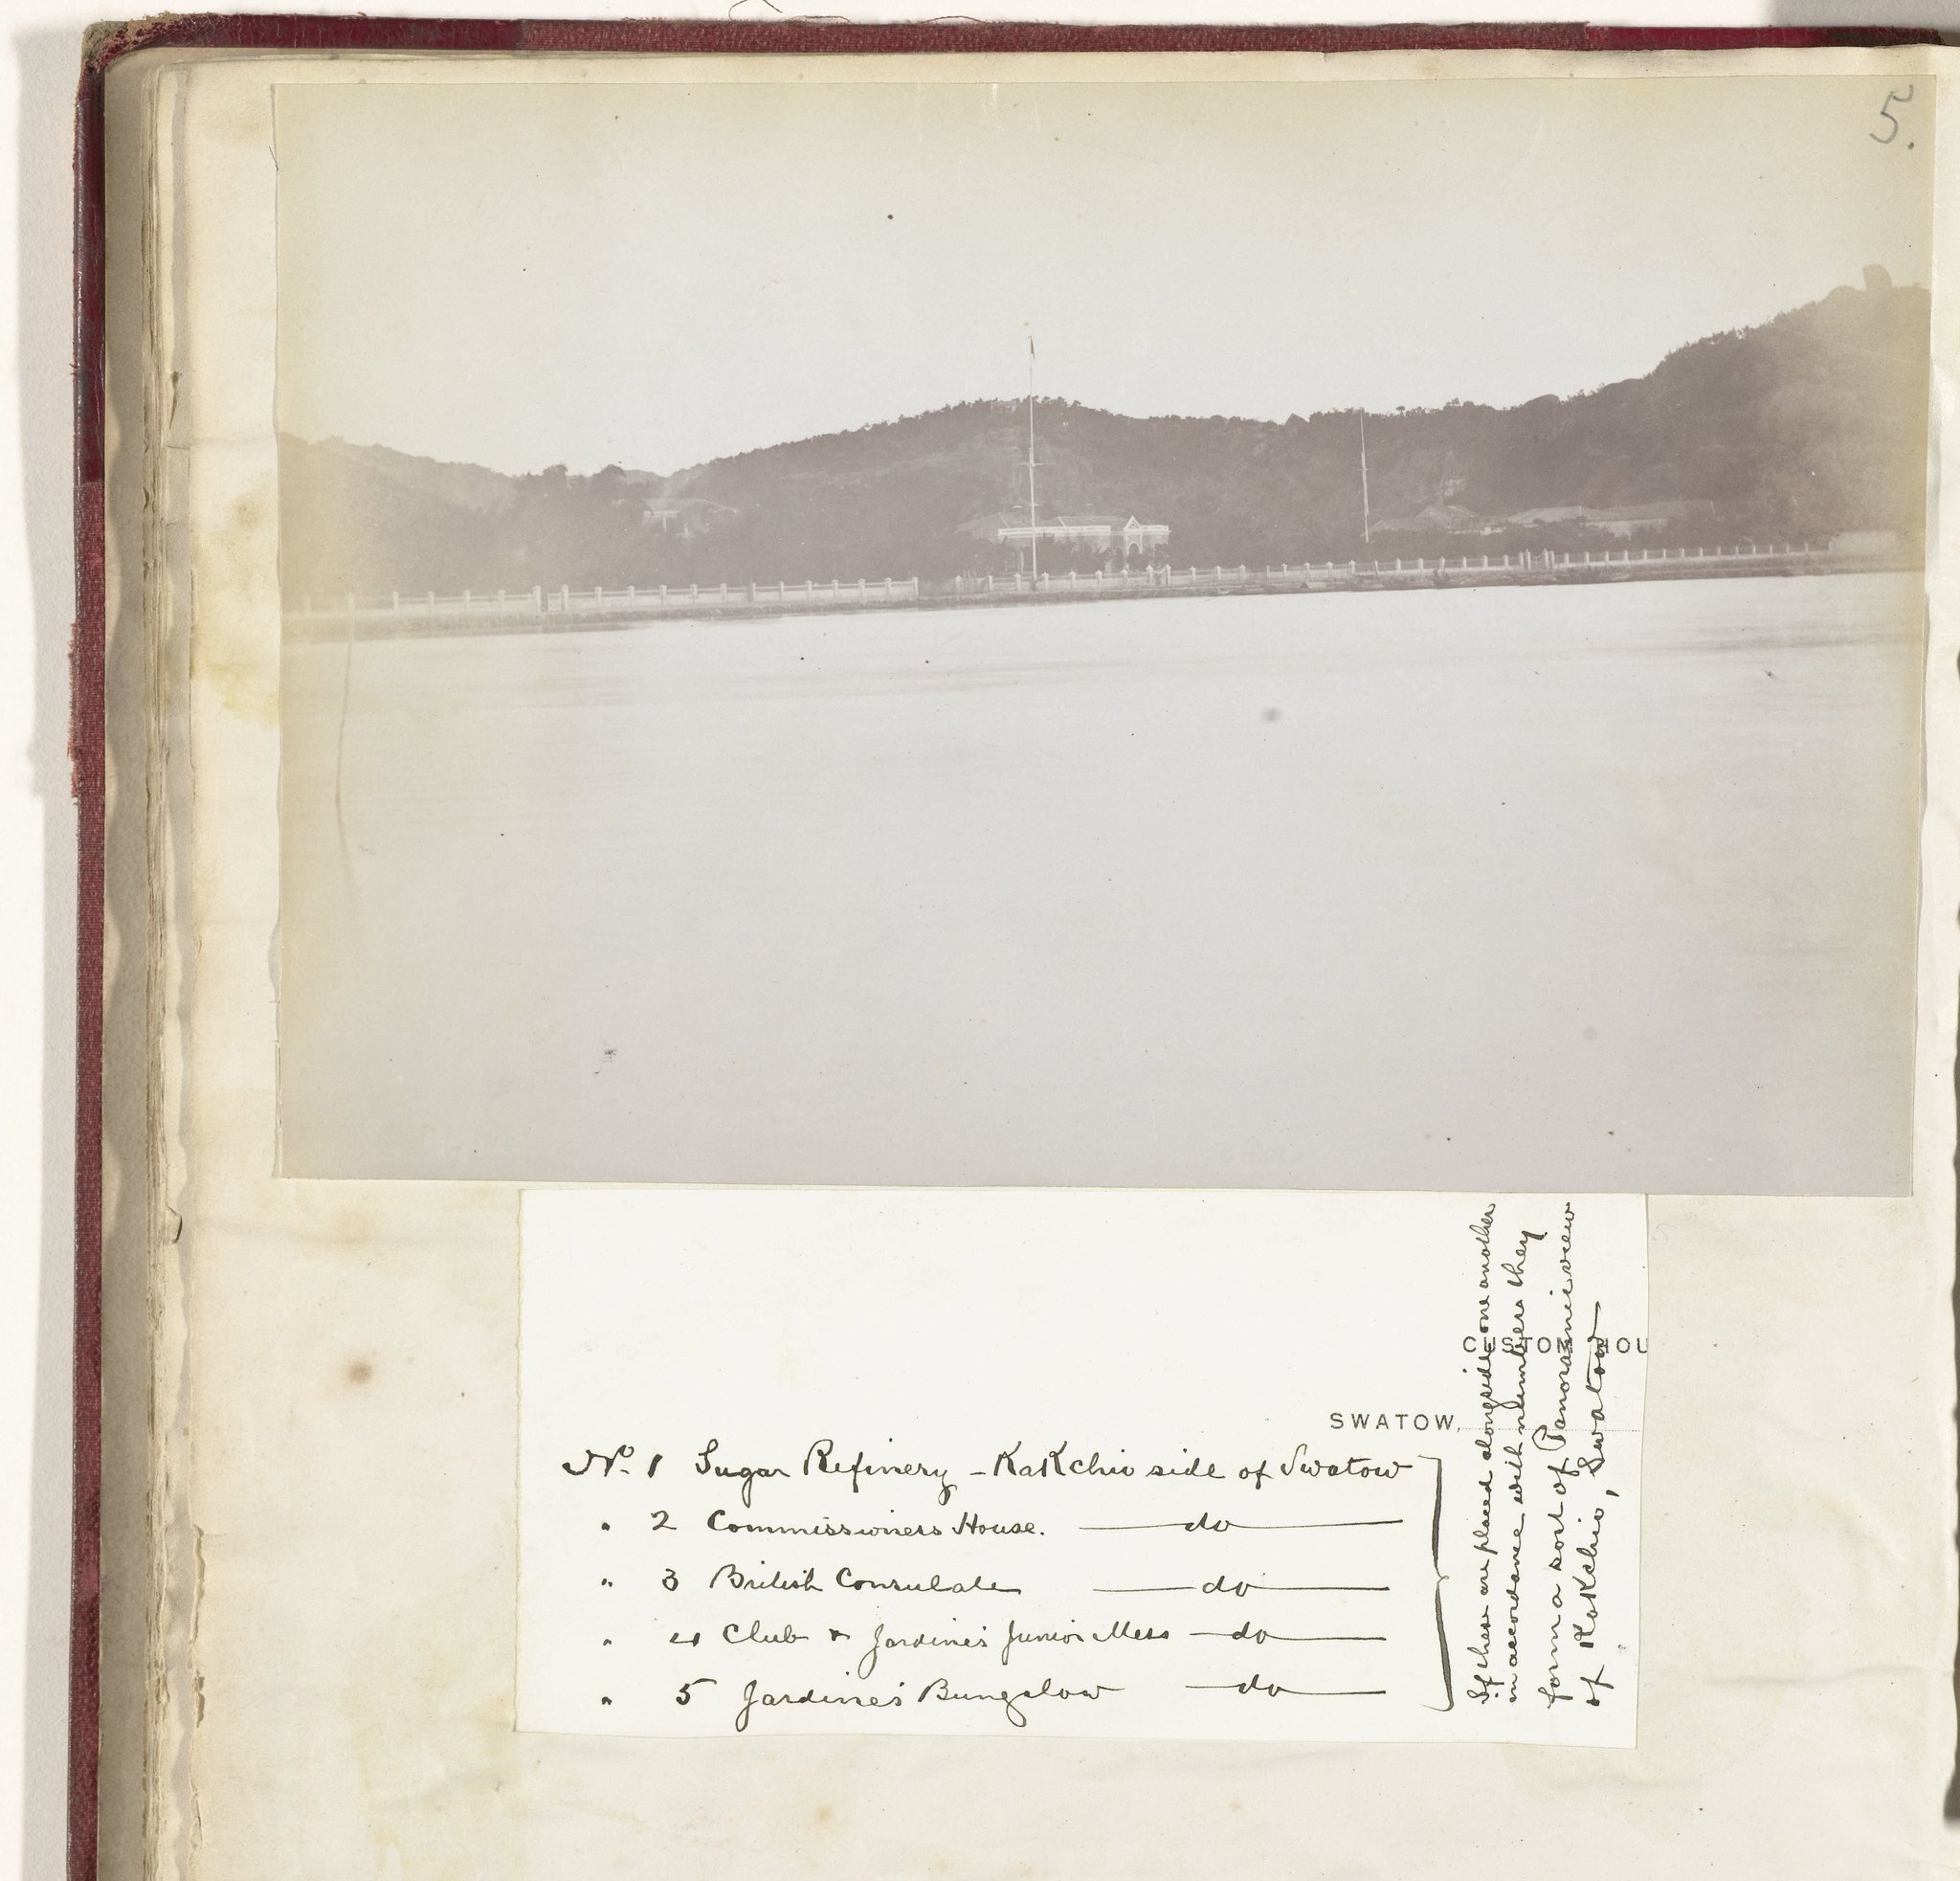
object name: photograph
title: Jardine's Bungalow - Kakchio side of Swatow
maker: Anonymous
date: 1879-1890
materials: paper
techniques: albumen print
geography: china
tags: coast, country-house, shantou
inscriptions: inscription: ‘5. These are placed alongside one another in accordance with numbers they form a sort of panoramic view of Kakchoi, Swatow.’, number: ‘5.’